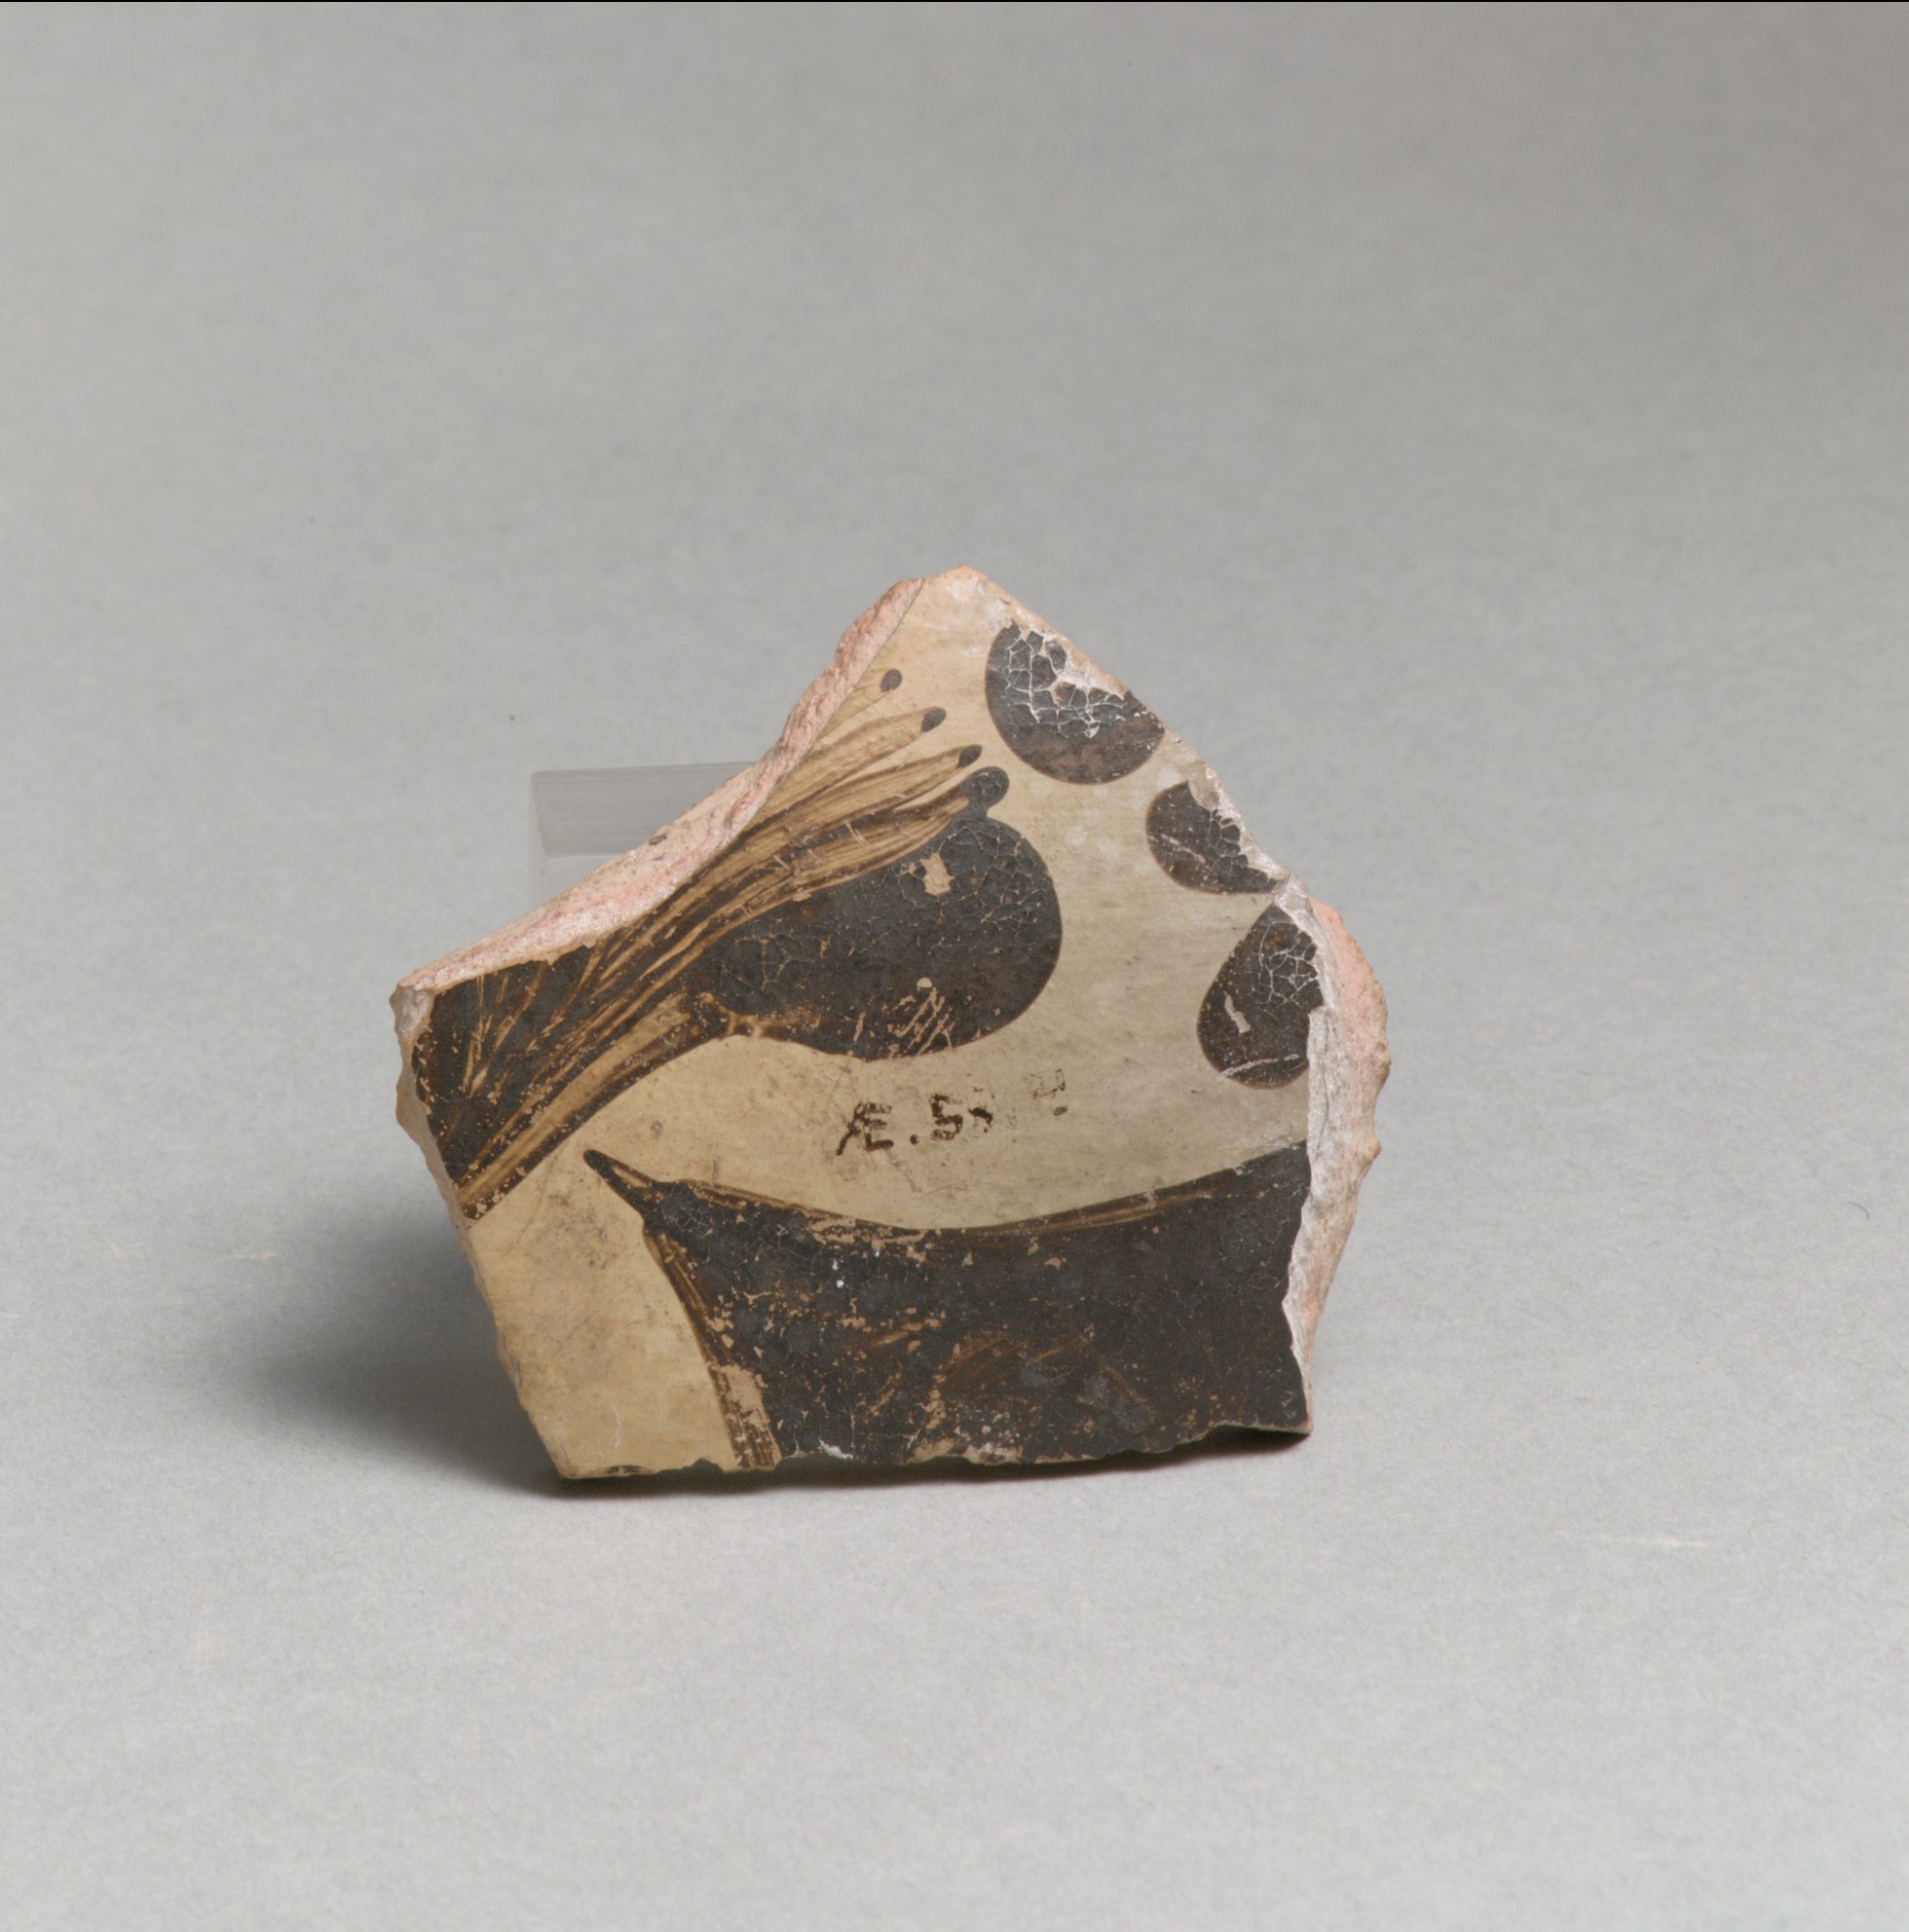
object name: vase fragment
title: Terracotta vessel fragment with floral design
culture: minoan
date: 1600-1450 BCE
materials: terracotta